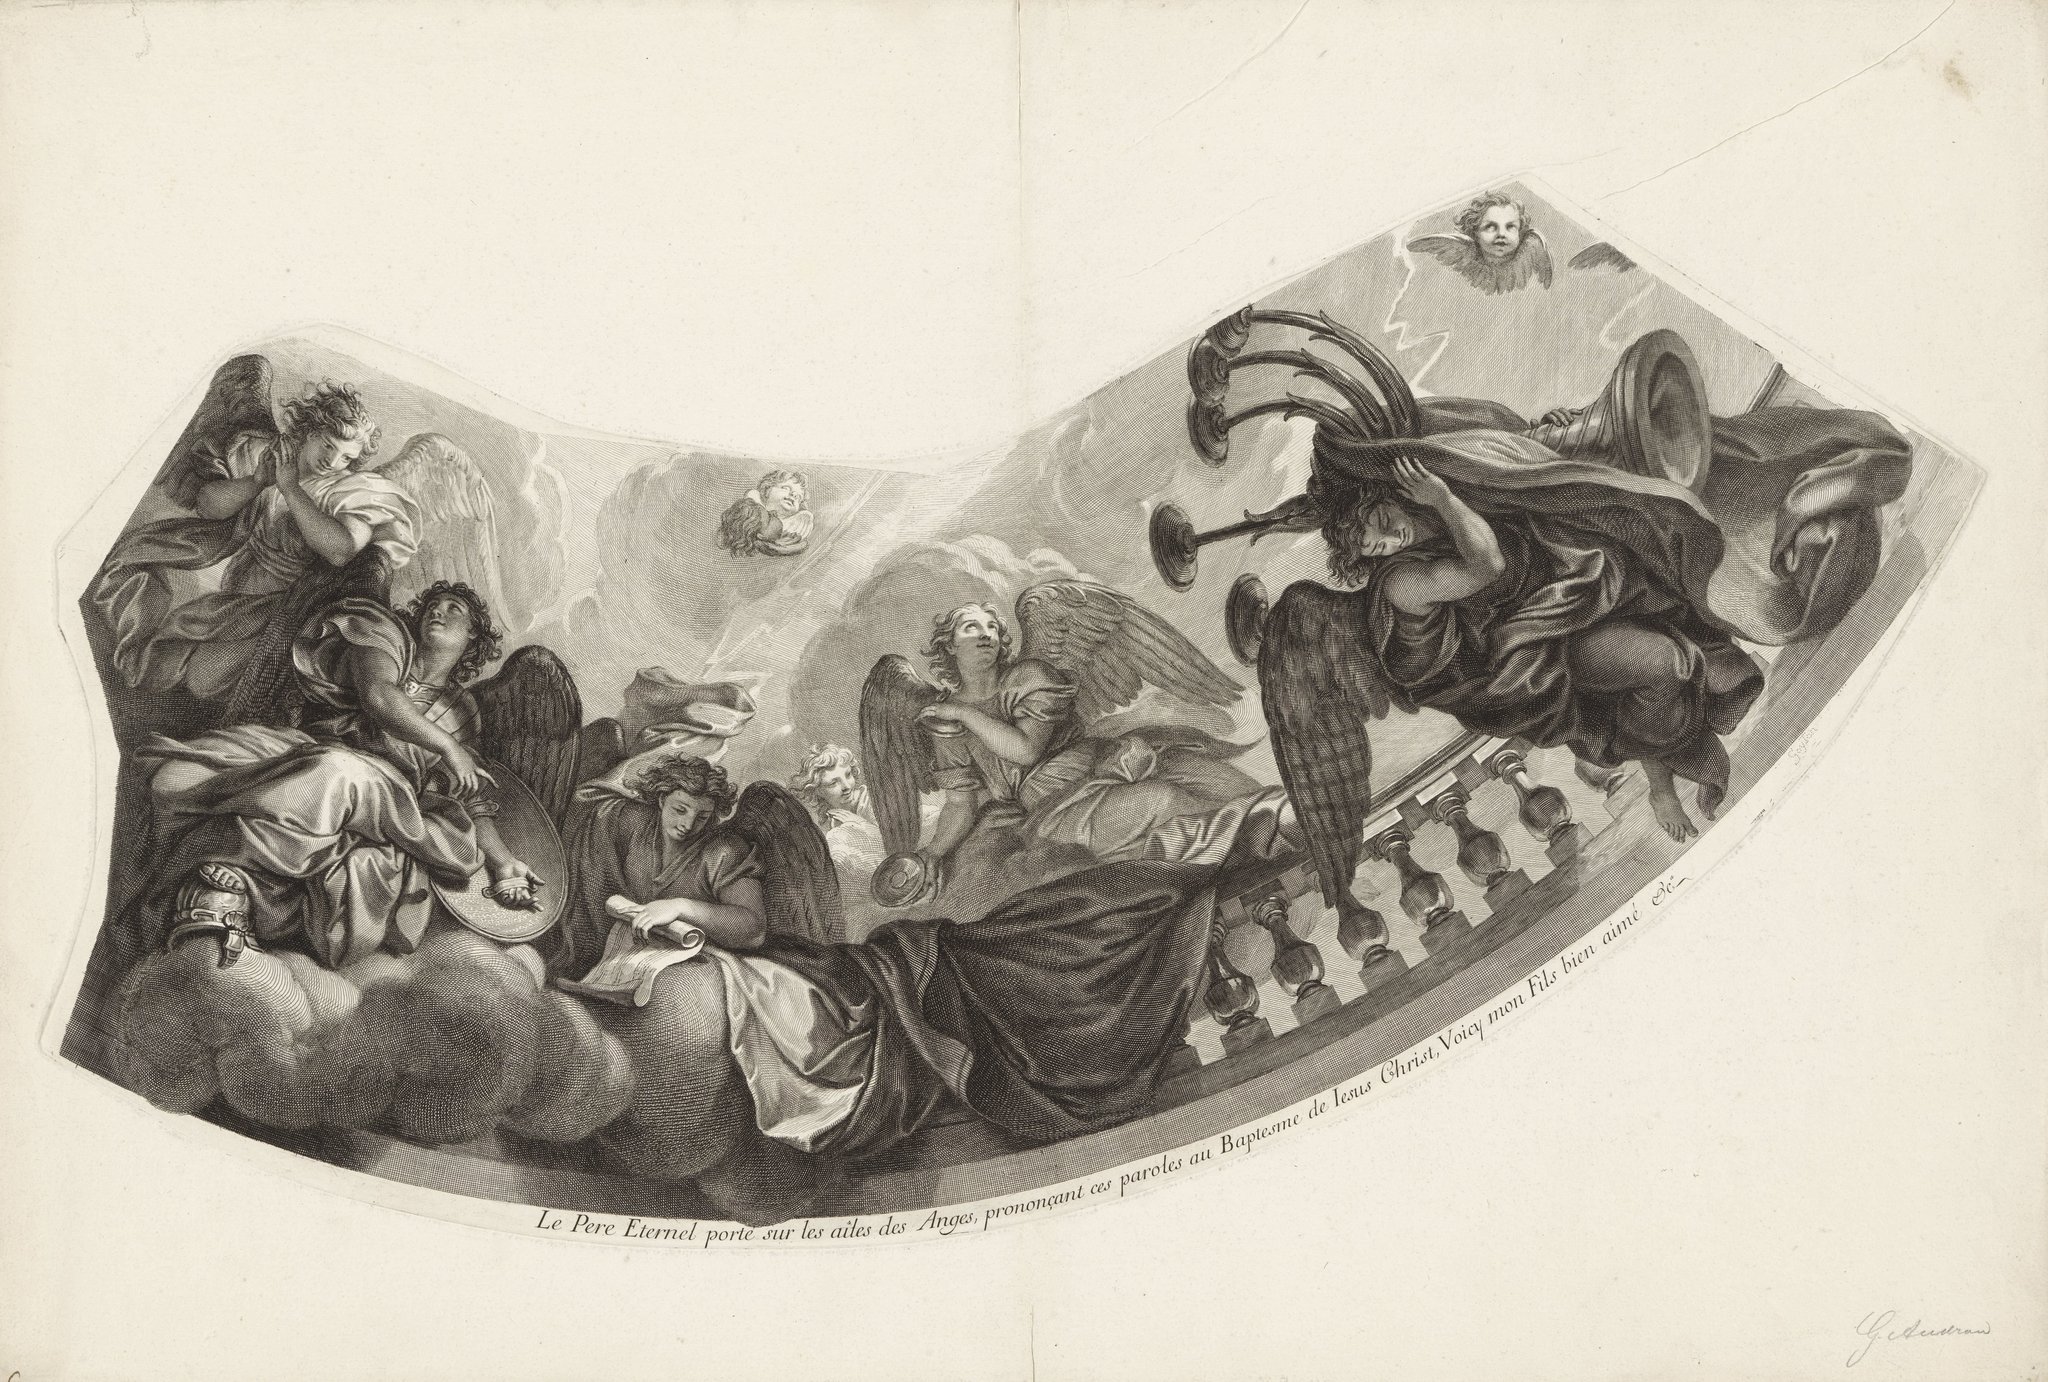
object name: print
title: Plafondschildering van de kapel van Château de Sceaux met engelen met verschillende attributen (plaat 2)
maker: gérard audran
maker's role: print maker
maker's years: 1640-1703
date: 1681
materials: paper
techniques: engraving, etching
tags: angels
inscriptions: collector's mark: Lugt 240, collector's mark: Lugt 1838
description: Prent kan worden samengevoegd met de vier andere prenten om de hele koepel te vormen.